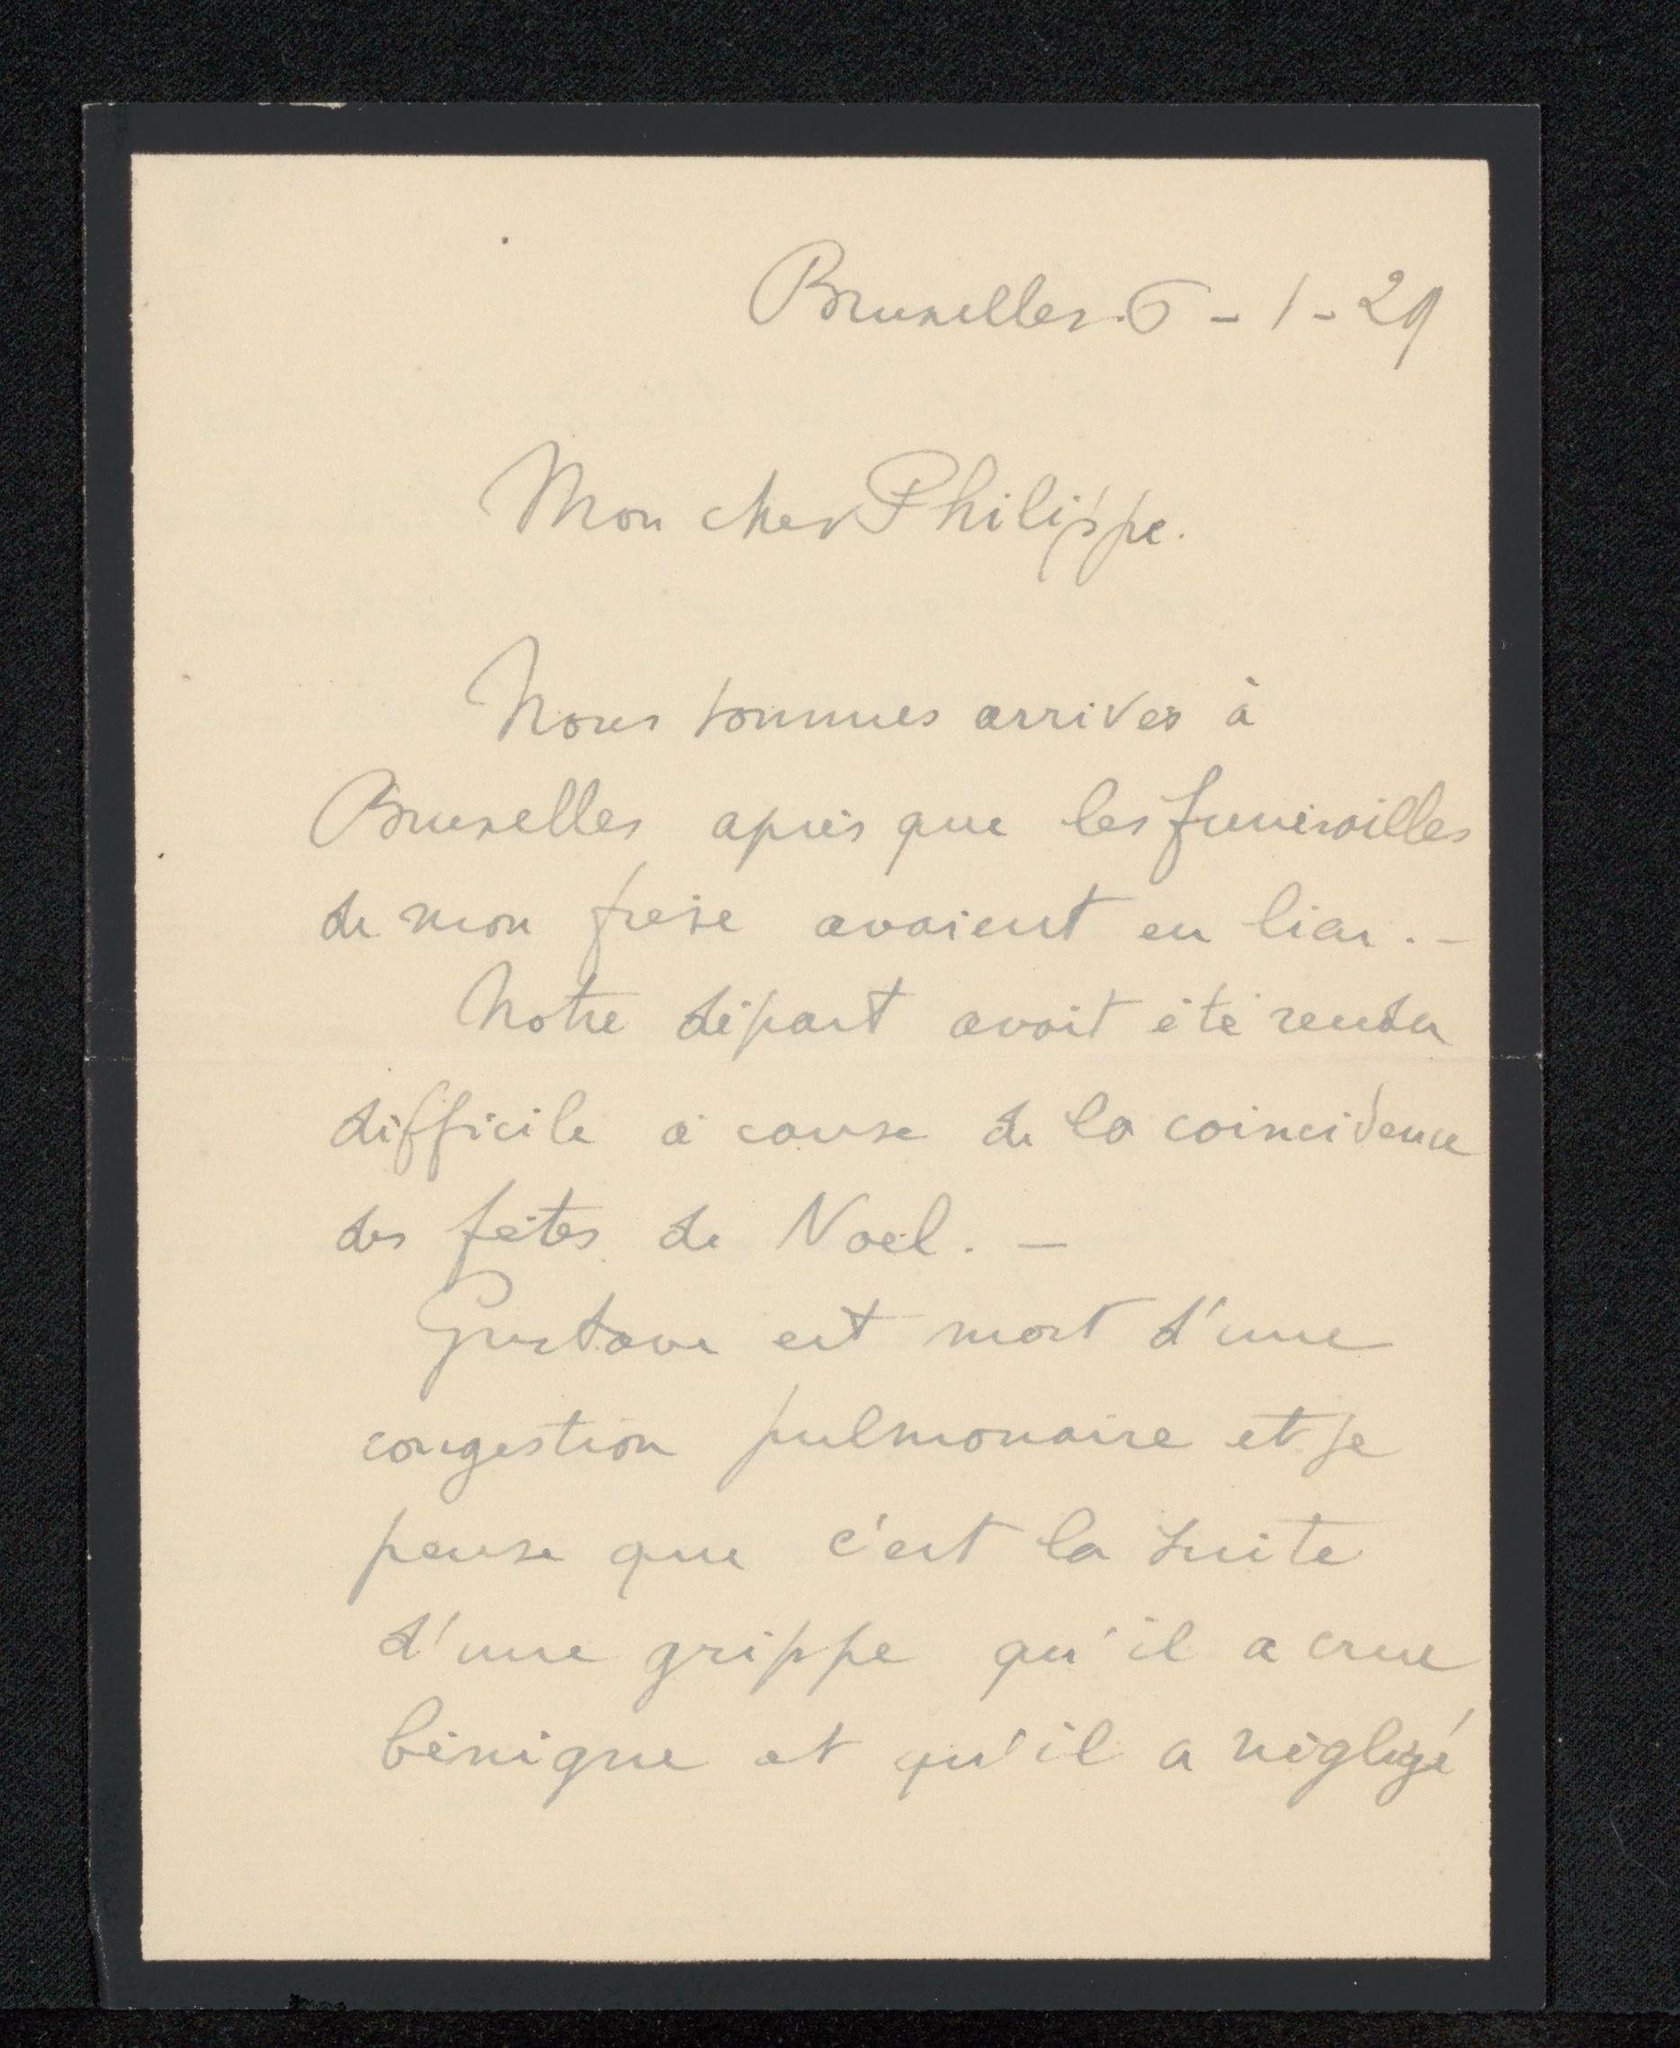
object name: letter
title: Brief aan Philip Zilcken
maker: ch. van moorsel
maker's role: schrijver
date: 1929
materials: ink, paper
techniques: pen, writing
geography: brussels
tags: the hague, painter, draughtsman, philip zilcken, family life, diseases, brussels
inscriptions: collector's mark: ‘RPK’, watermark